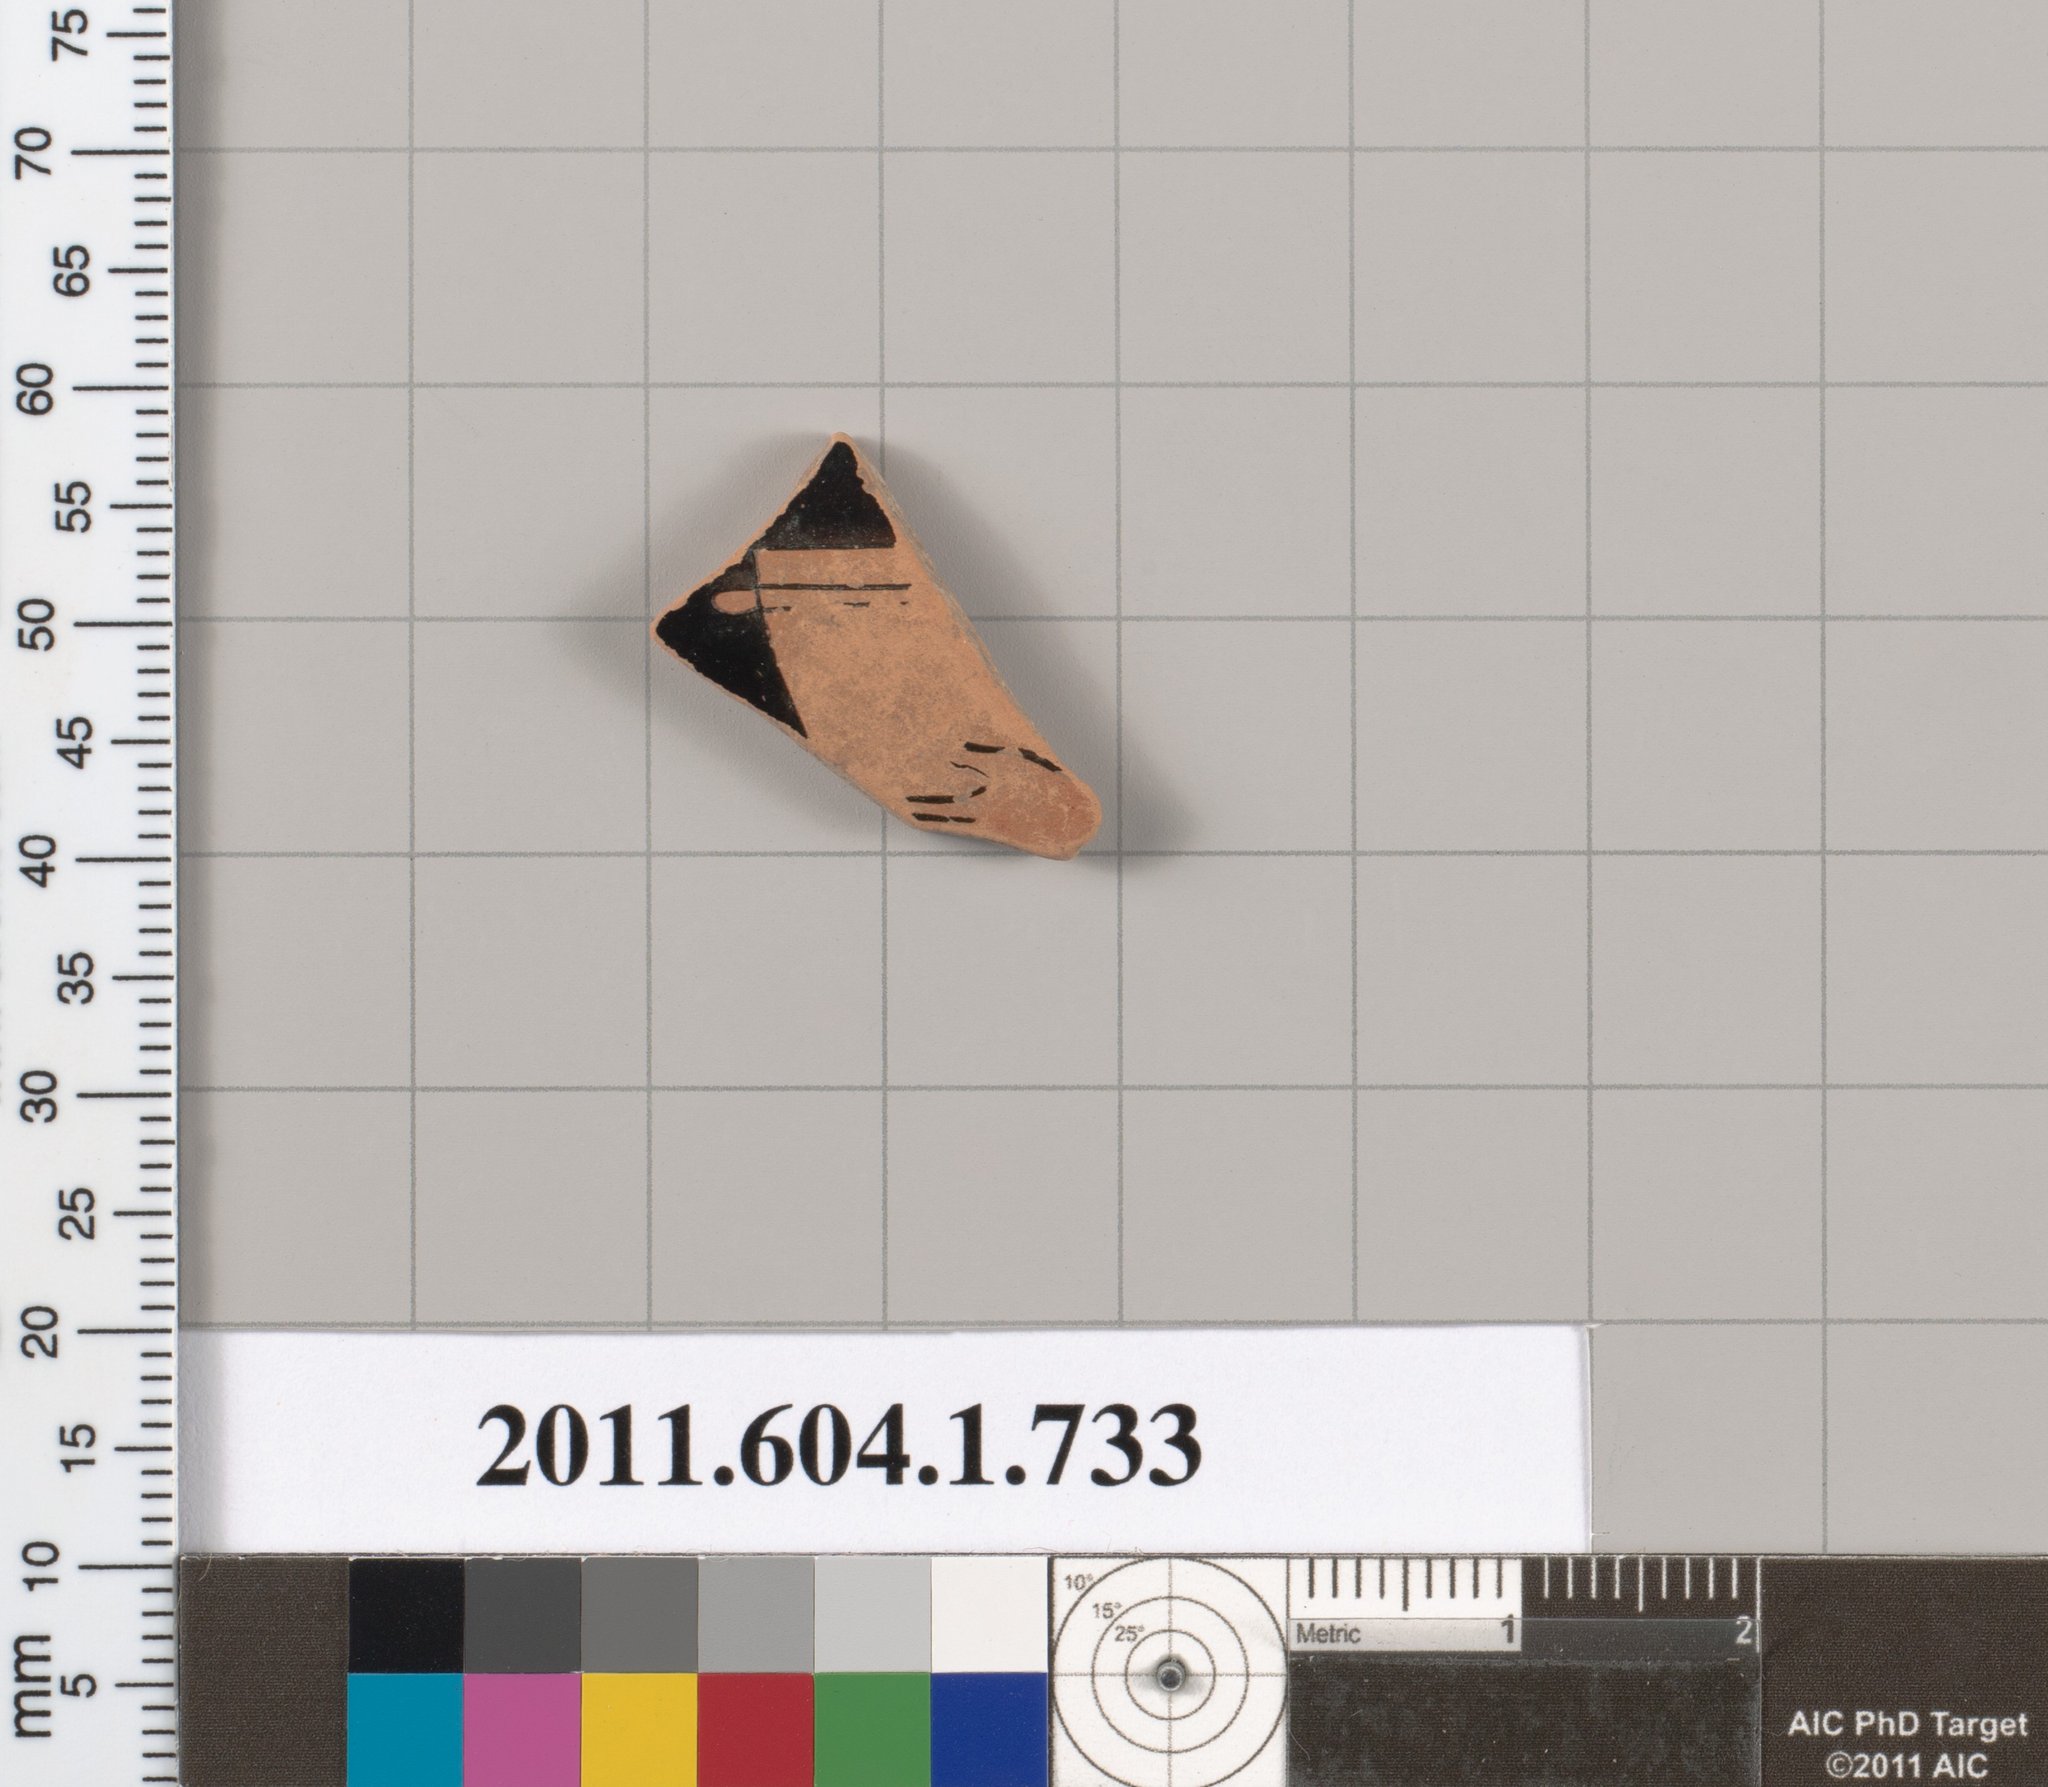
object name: kylix fragment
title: Terracotta fragment of a kylix (drinking cup)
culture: greek, attic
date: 475-451 BCE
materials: terracotta